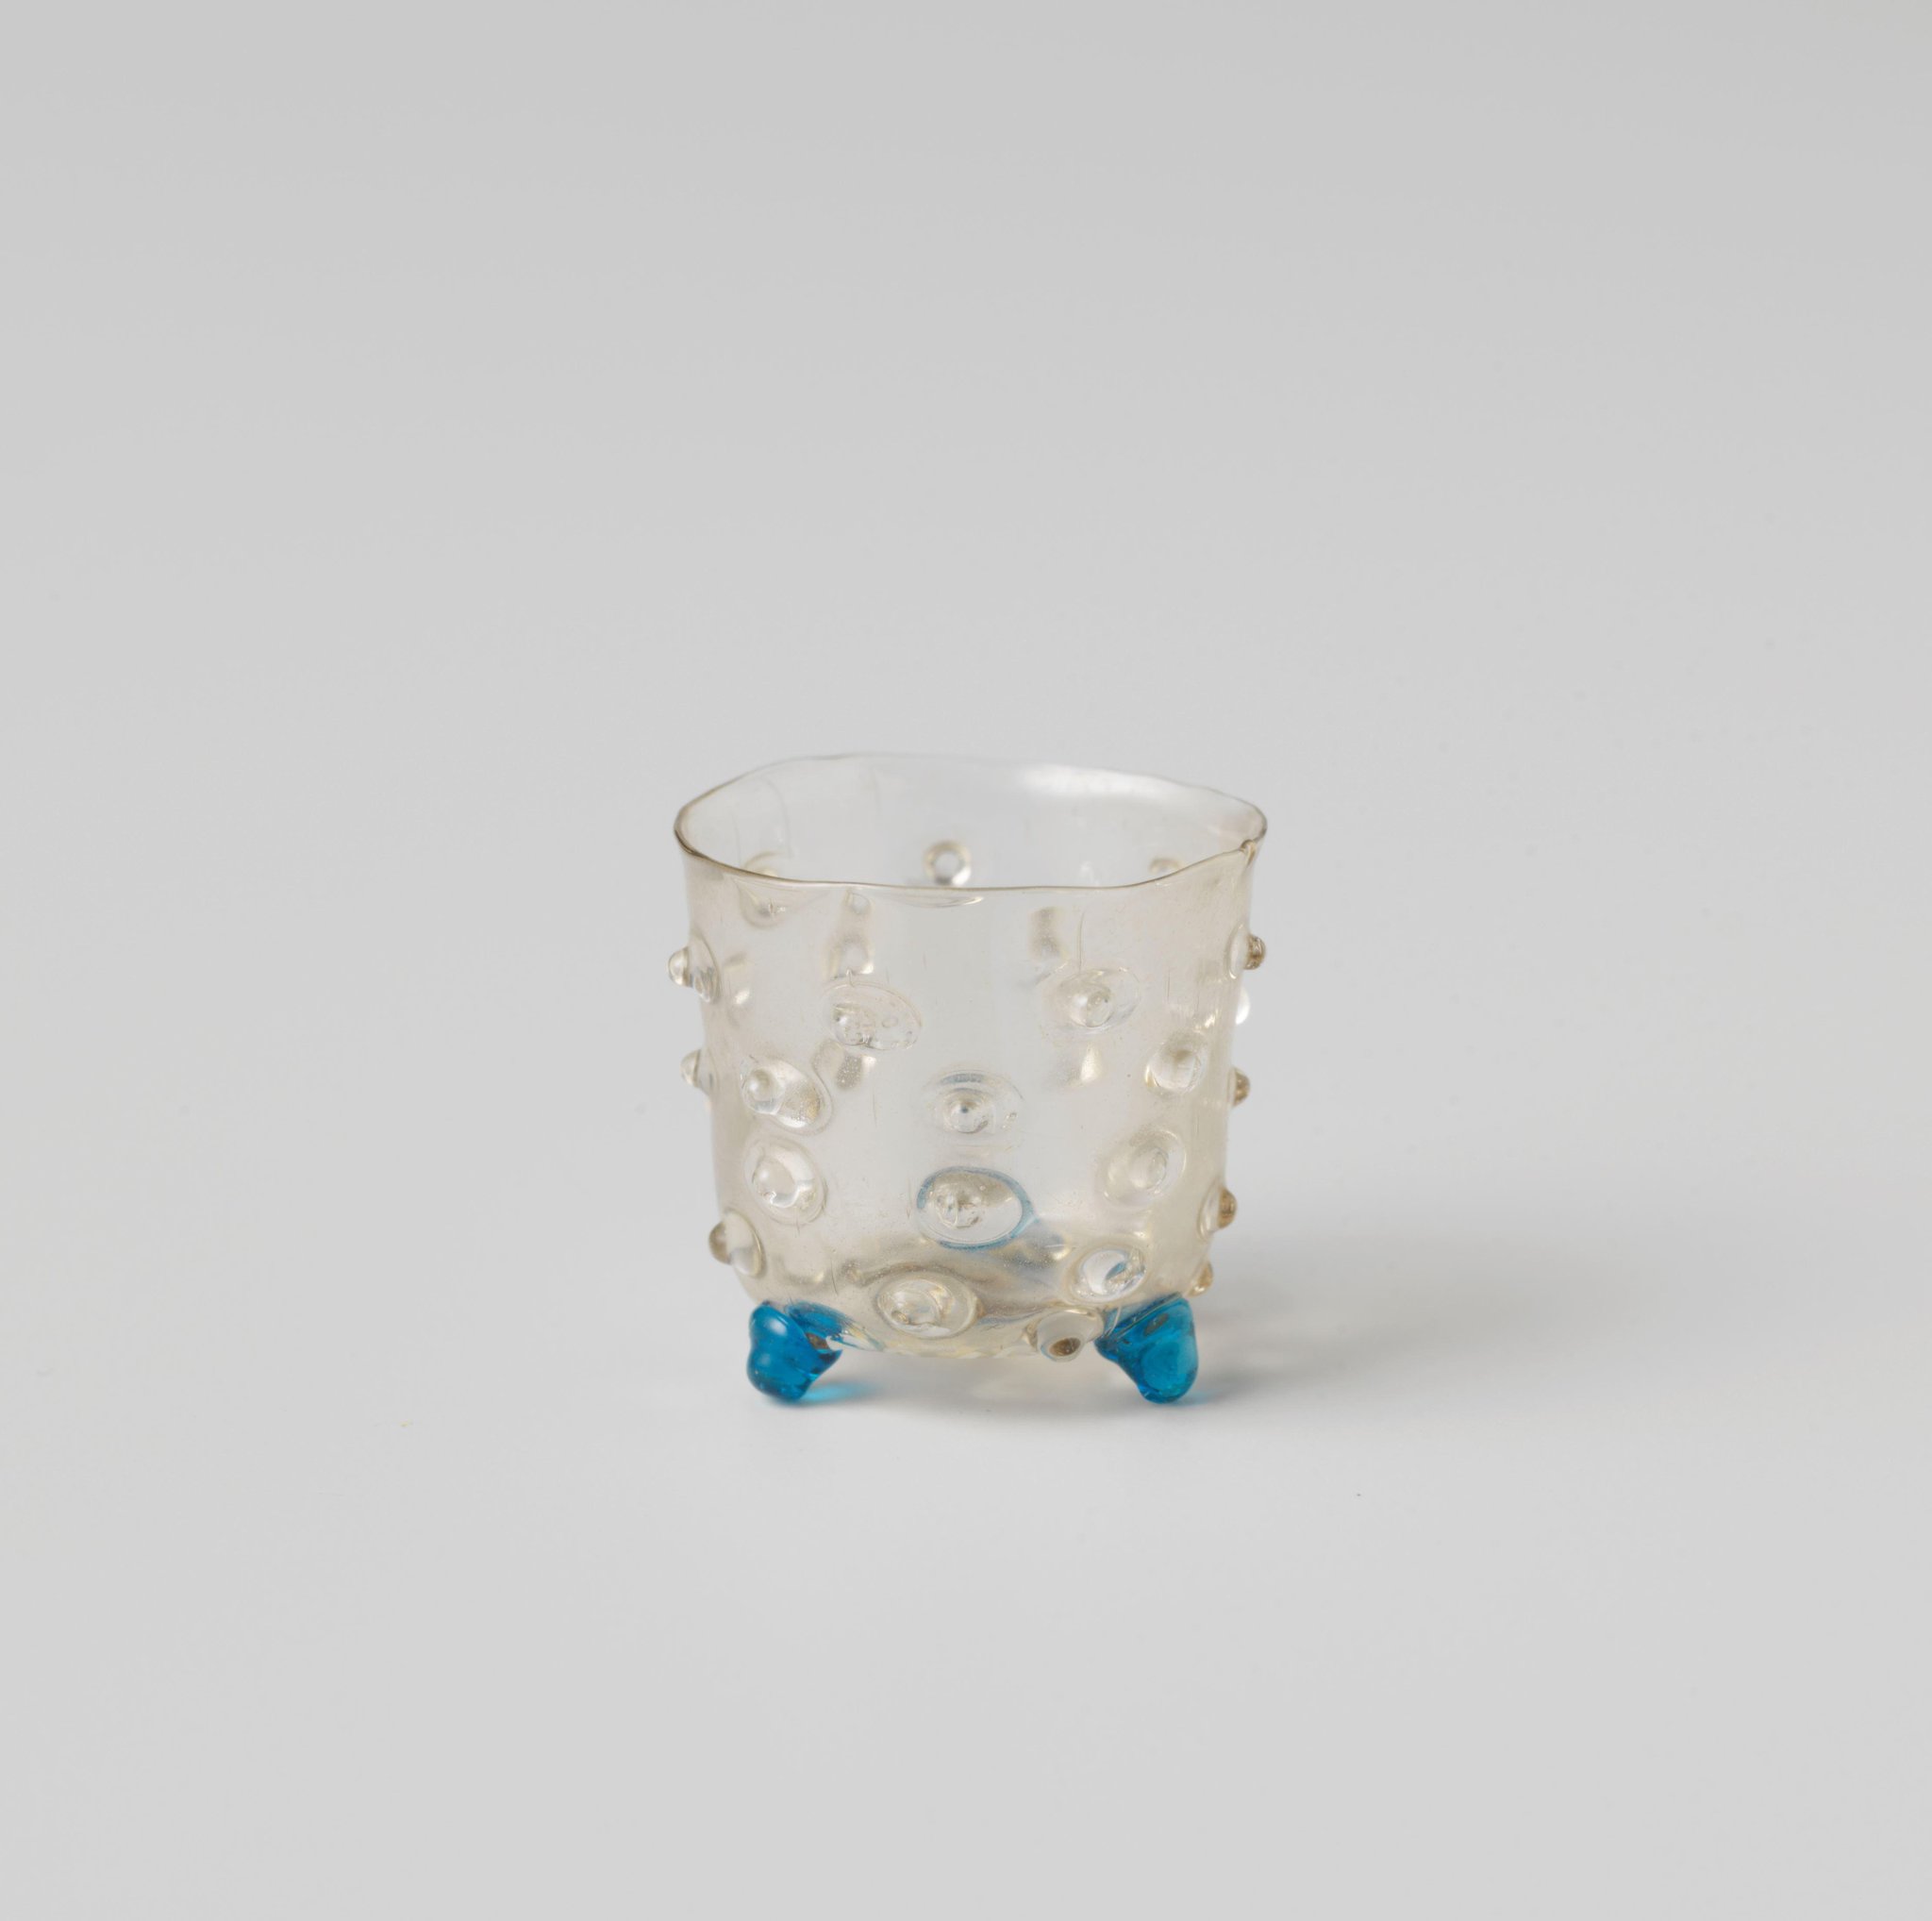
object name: miniature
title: Beker versierd met wratten en noppen, op drie bolpoten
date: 1675-1699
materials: glass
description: Beker van helder kleurloos glas versierd met wratten en noppen, op drie blauwe bolpoten.